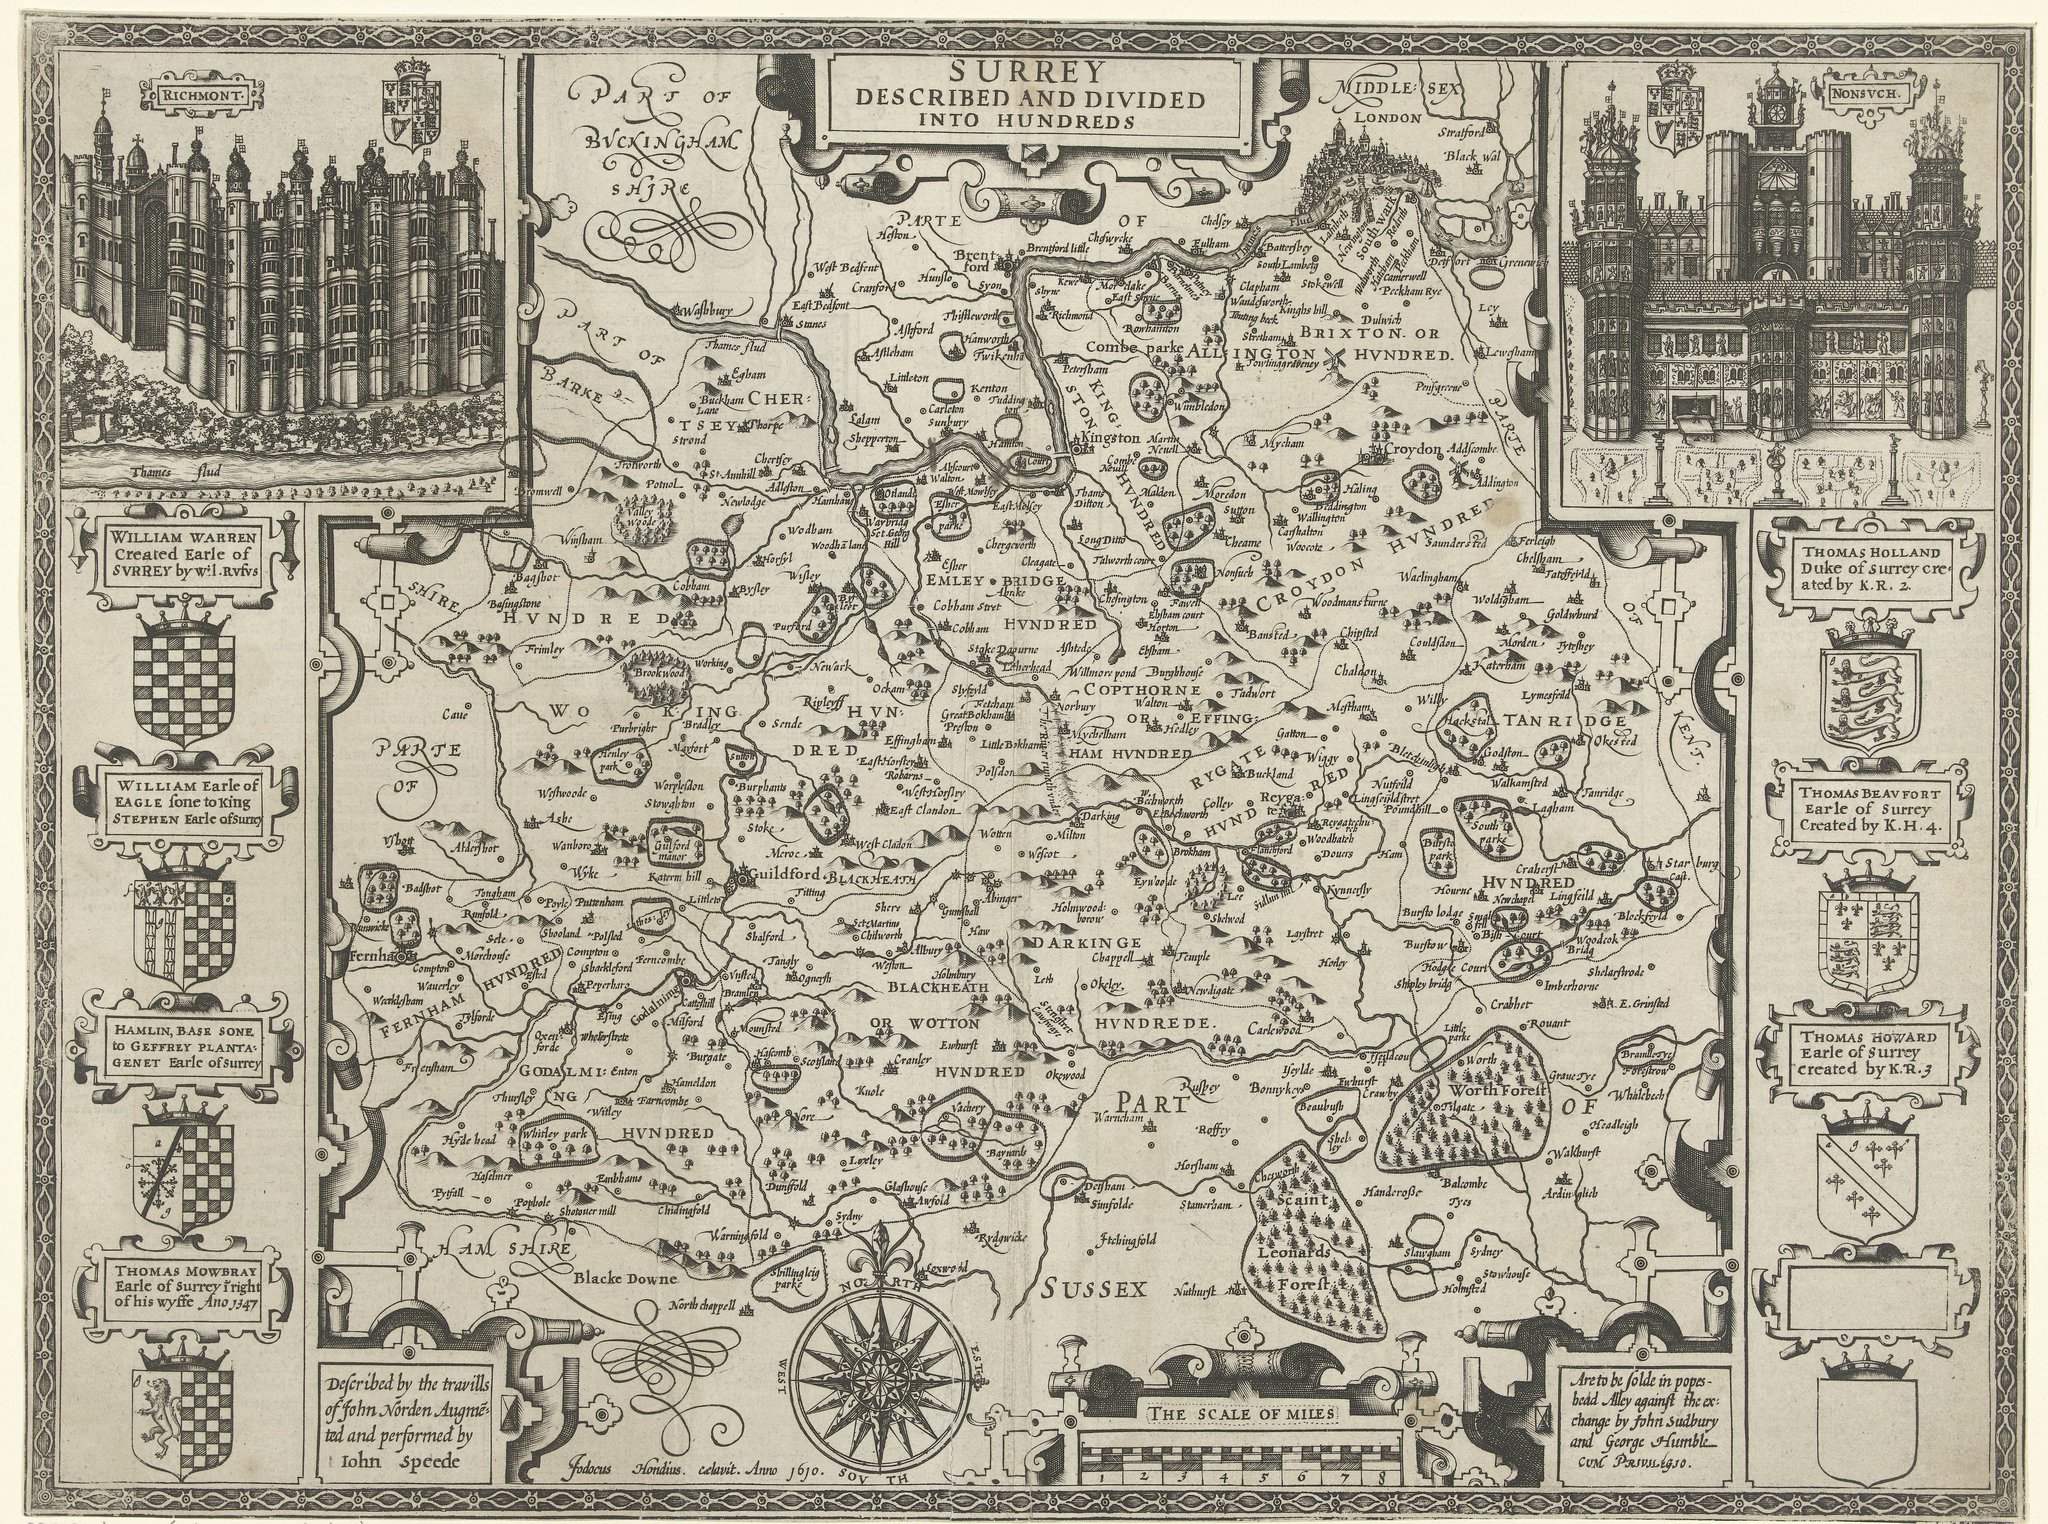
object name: map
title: Surrey described and divided into hundreds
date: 1610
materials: paper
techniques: engraving, etching, letterpress printing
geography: london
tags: nonsuch palace, surrey, richmond (surrey)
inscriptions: collector's mark: Lugt 2228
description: Kaart van Surrey, met rechtsboven een gezicht op Nonsuch en linksboven een gezicht op Richmond. Bovenaan in het midden de titel in een cartouche. Links en rechts een aantal wapens en cartouches, waarvan rechts enkele oningevuld. Onderaan een kompas en een schaal.